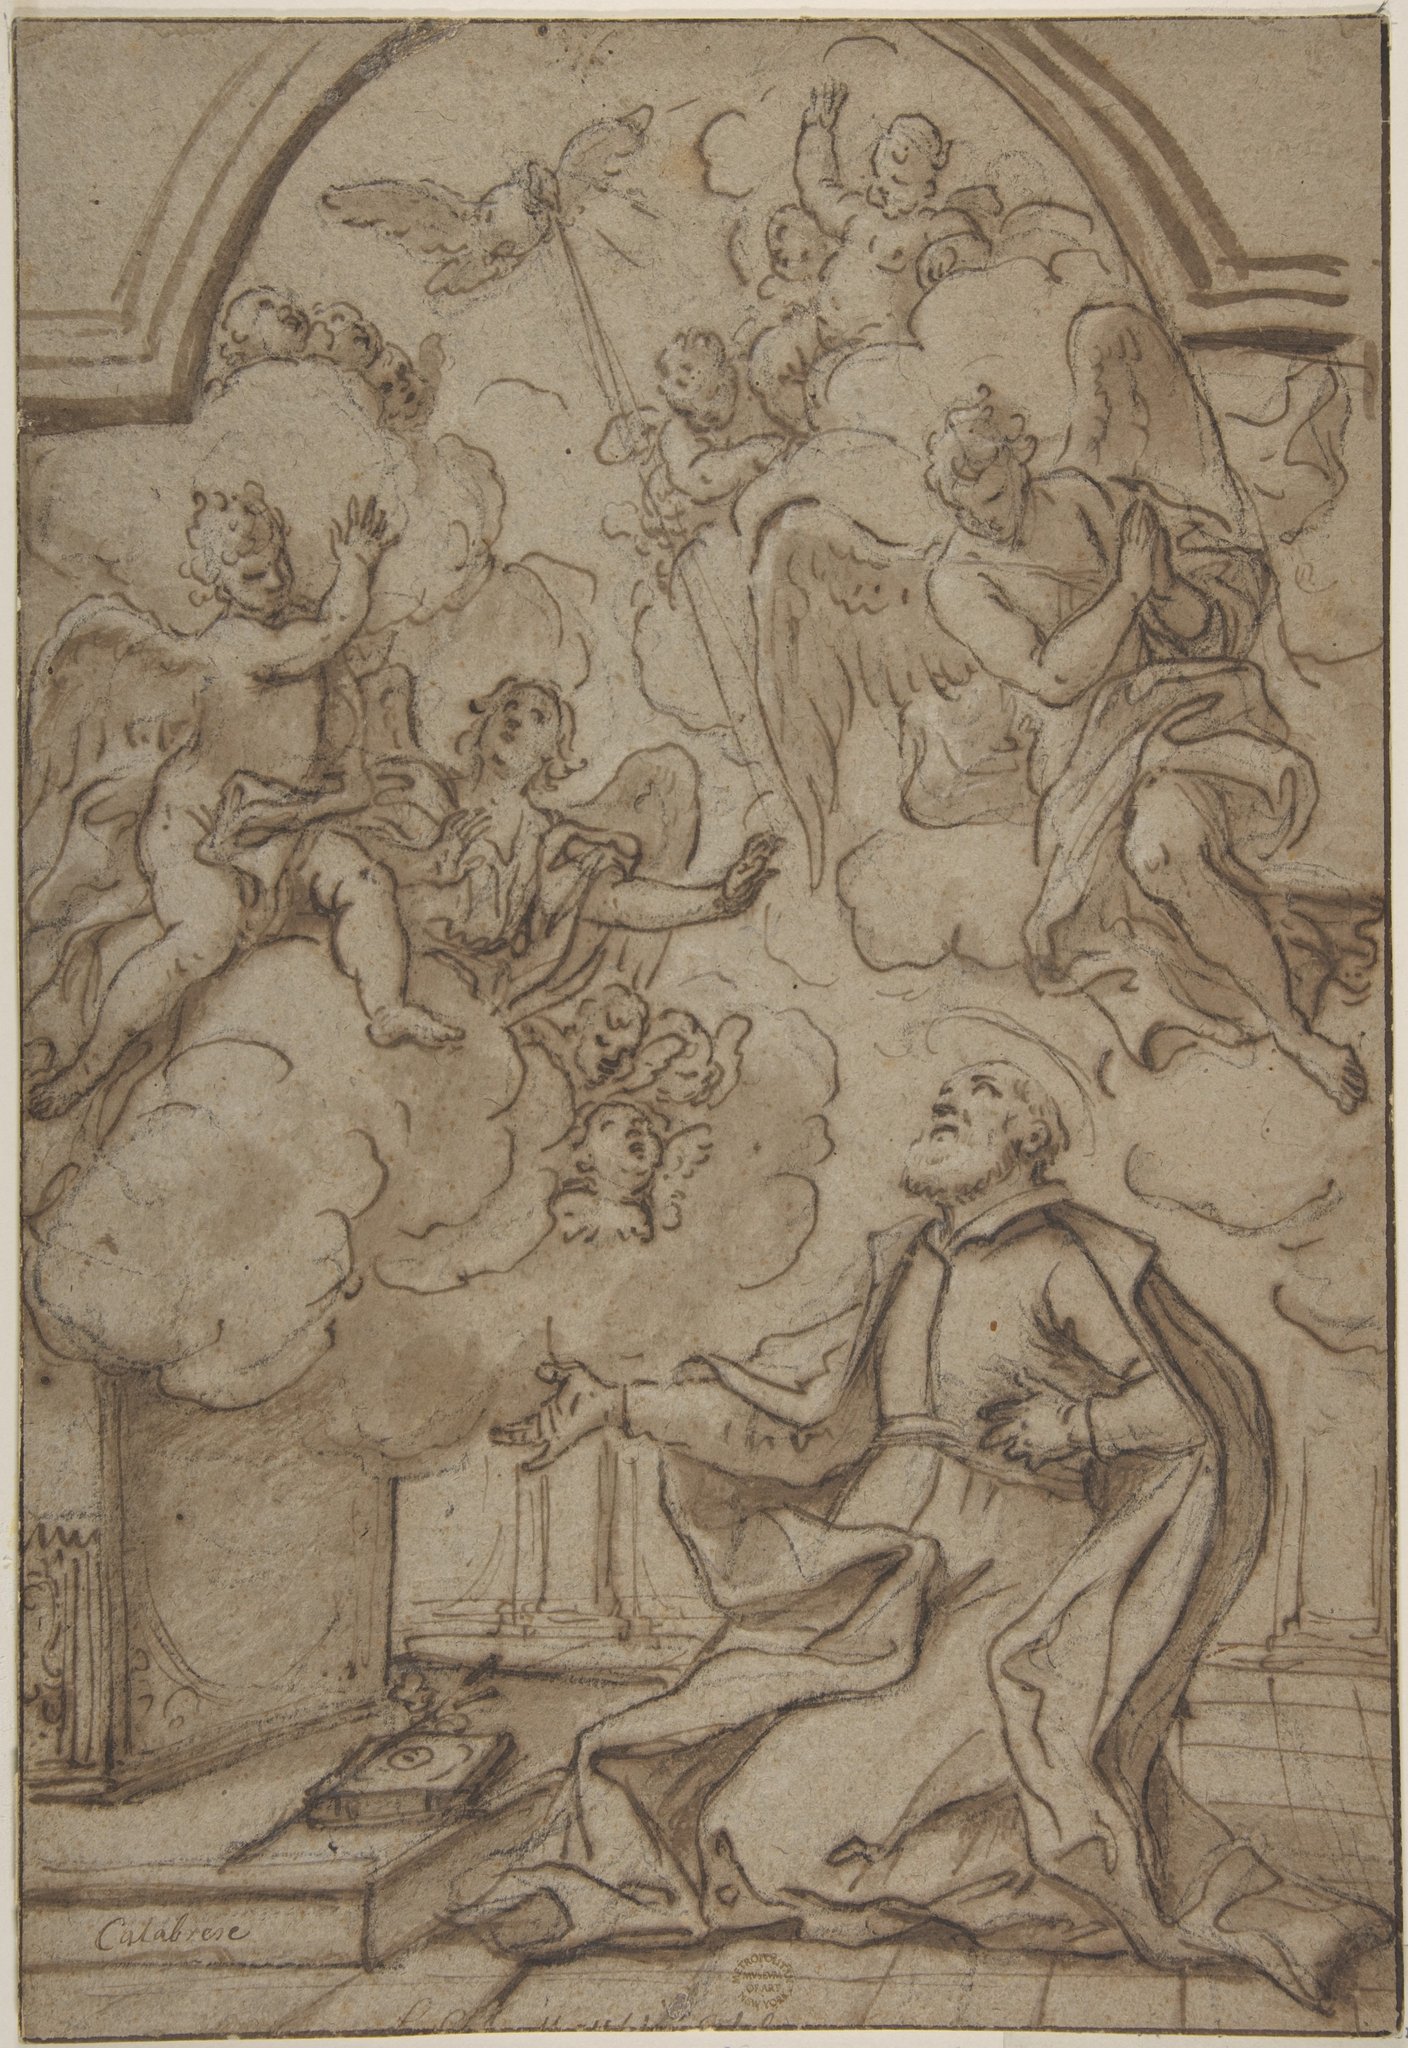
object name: drawing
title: Saint in Ecstasy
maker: mattia preti (il cavalier calabrese)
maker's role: artist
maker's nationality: italian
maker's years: 1613-1699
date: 1613-1699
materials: ink, paper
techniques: pen, wash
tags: angels,saints